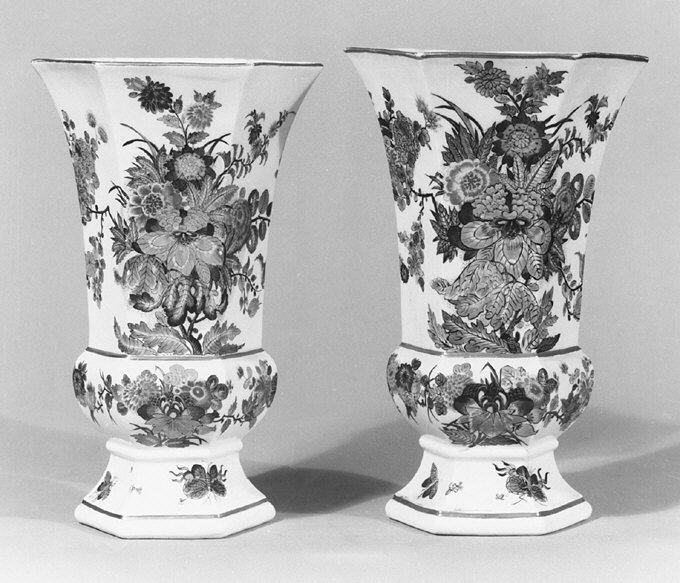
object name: vase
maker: meissen manufactory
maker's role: manufactory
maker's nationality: german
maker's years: 1710-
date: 1730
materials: hard paste porcelain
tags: flowers